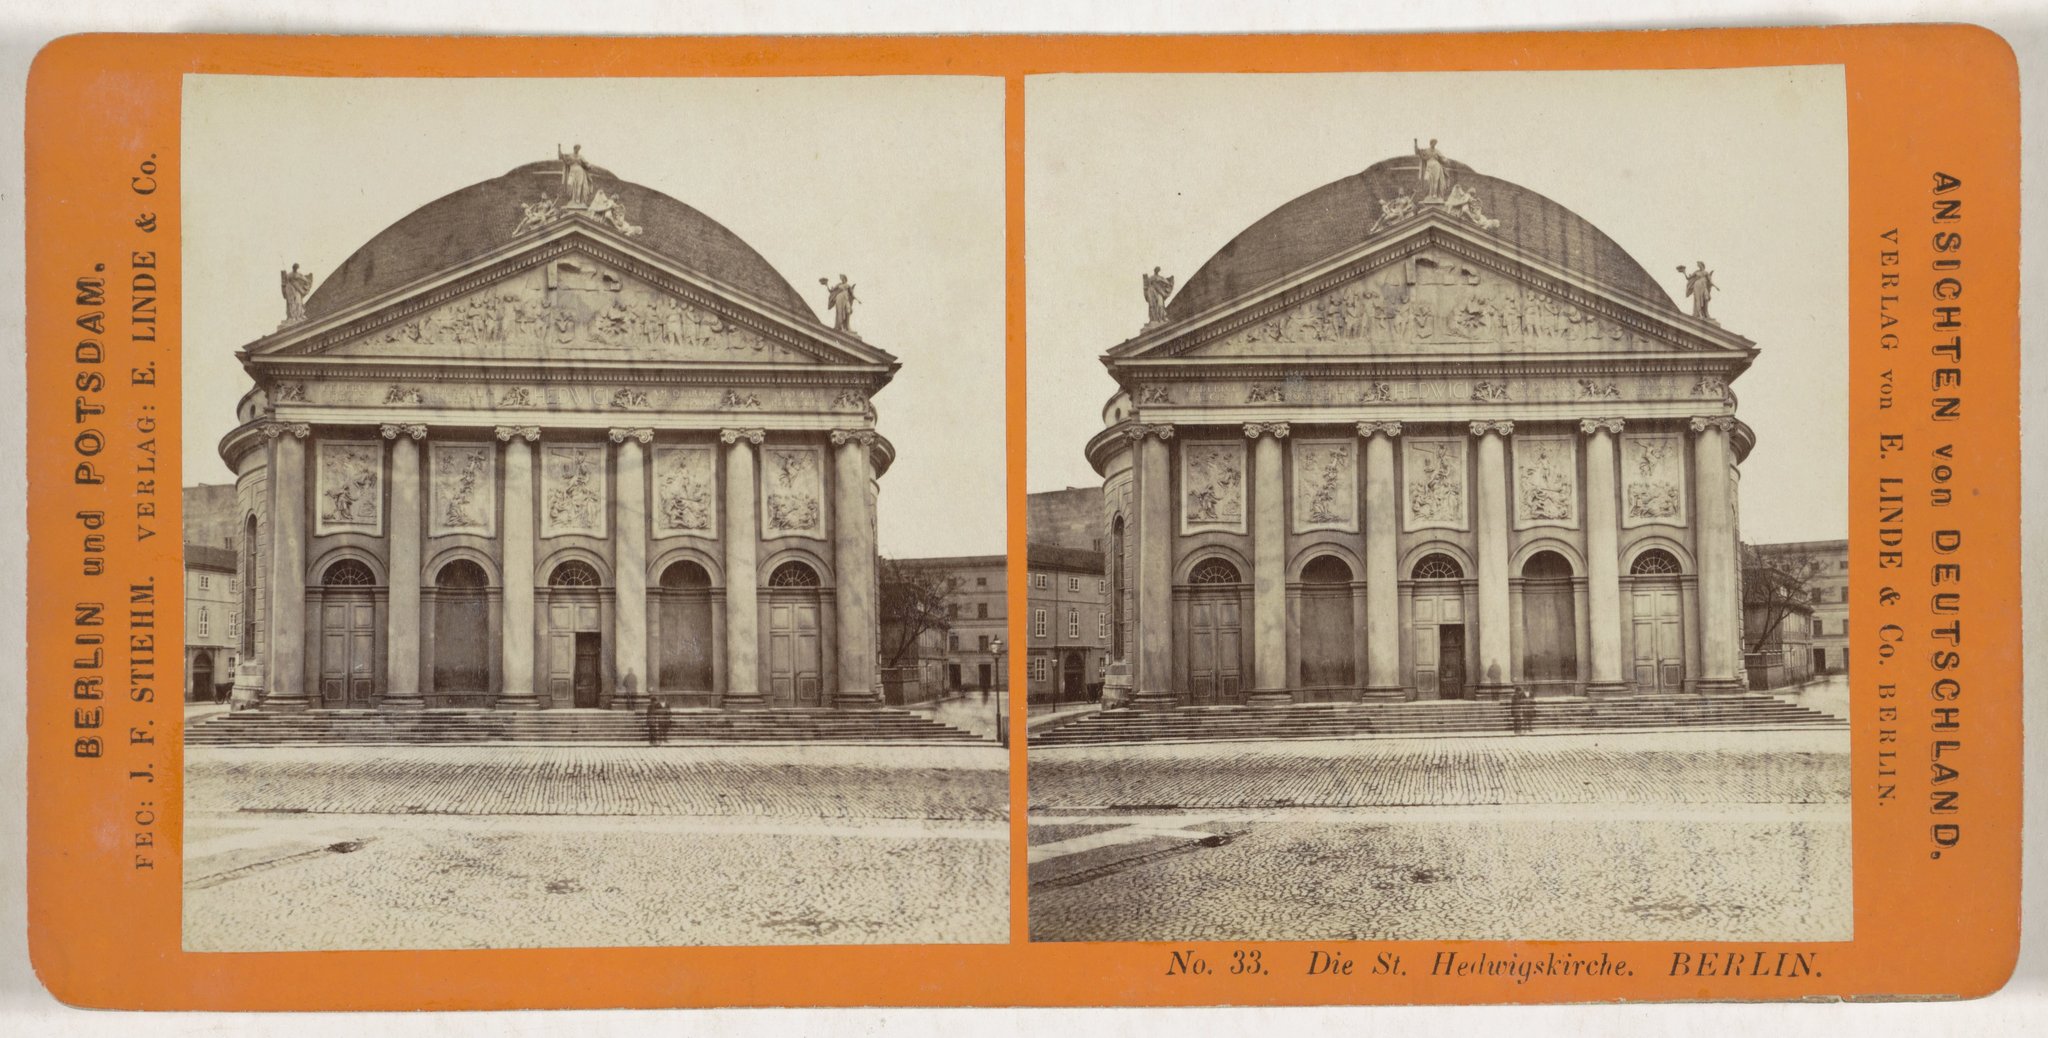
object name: stereograph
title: Ansichten von Deutschland / Berlin und Potsdam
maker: johann friedrich stiehm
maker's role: fotograaf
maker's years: 1826-1902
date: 1868-1870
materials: cardboard, paper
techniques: albumen print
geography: berlin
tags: roman catholic church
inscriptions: number: ‘No. 33.’